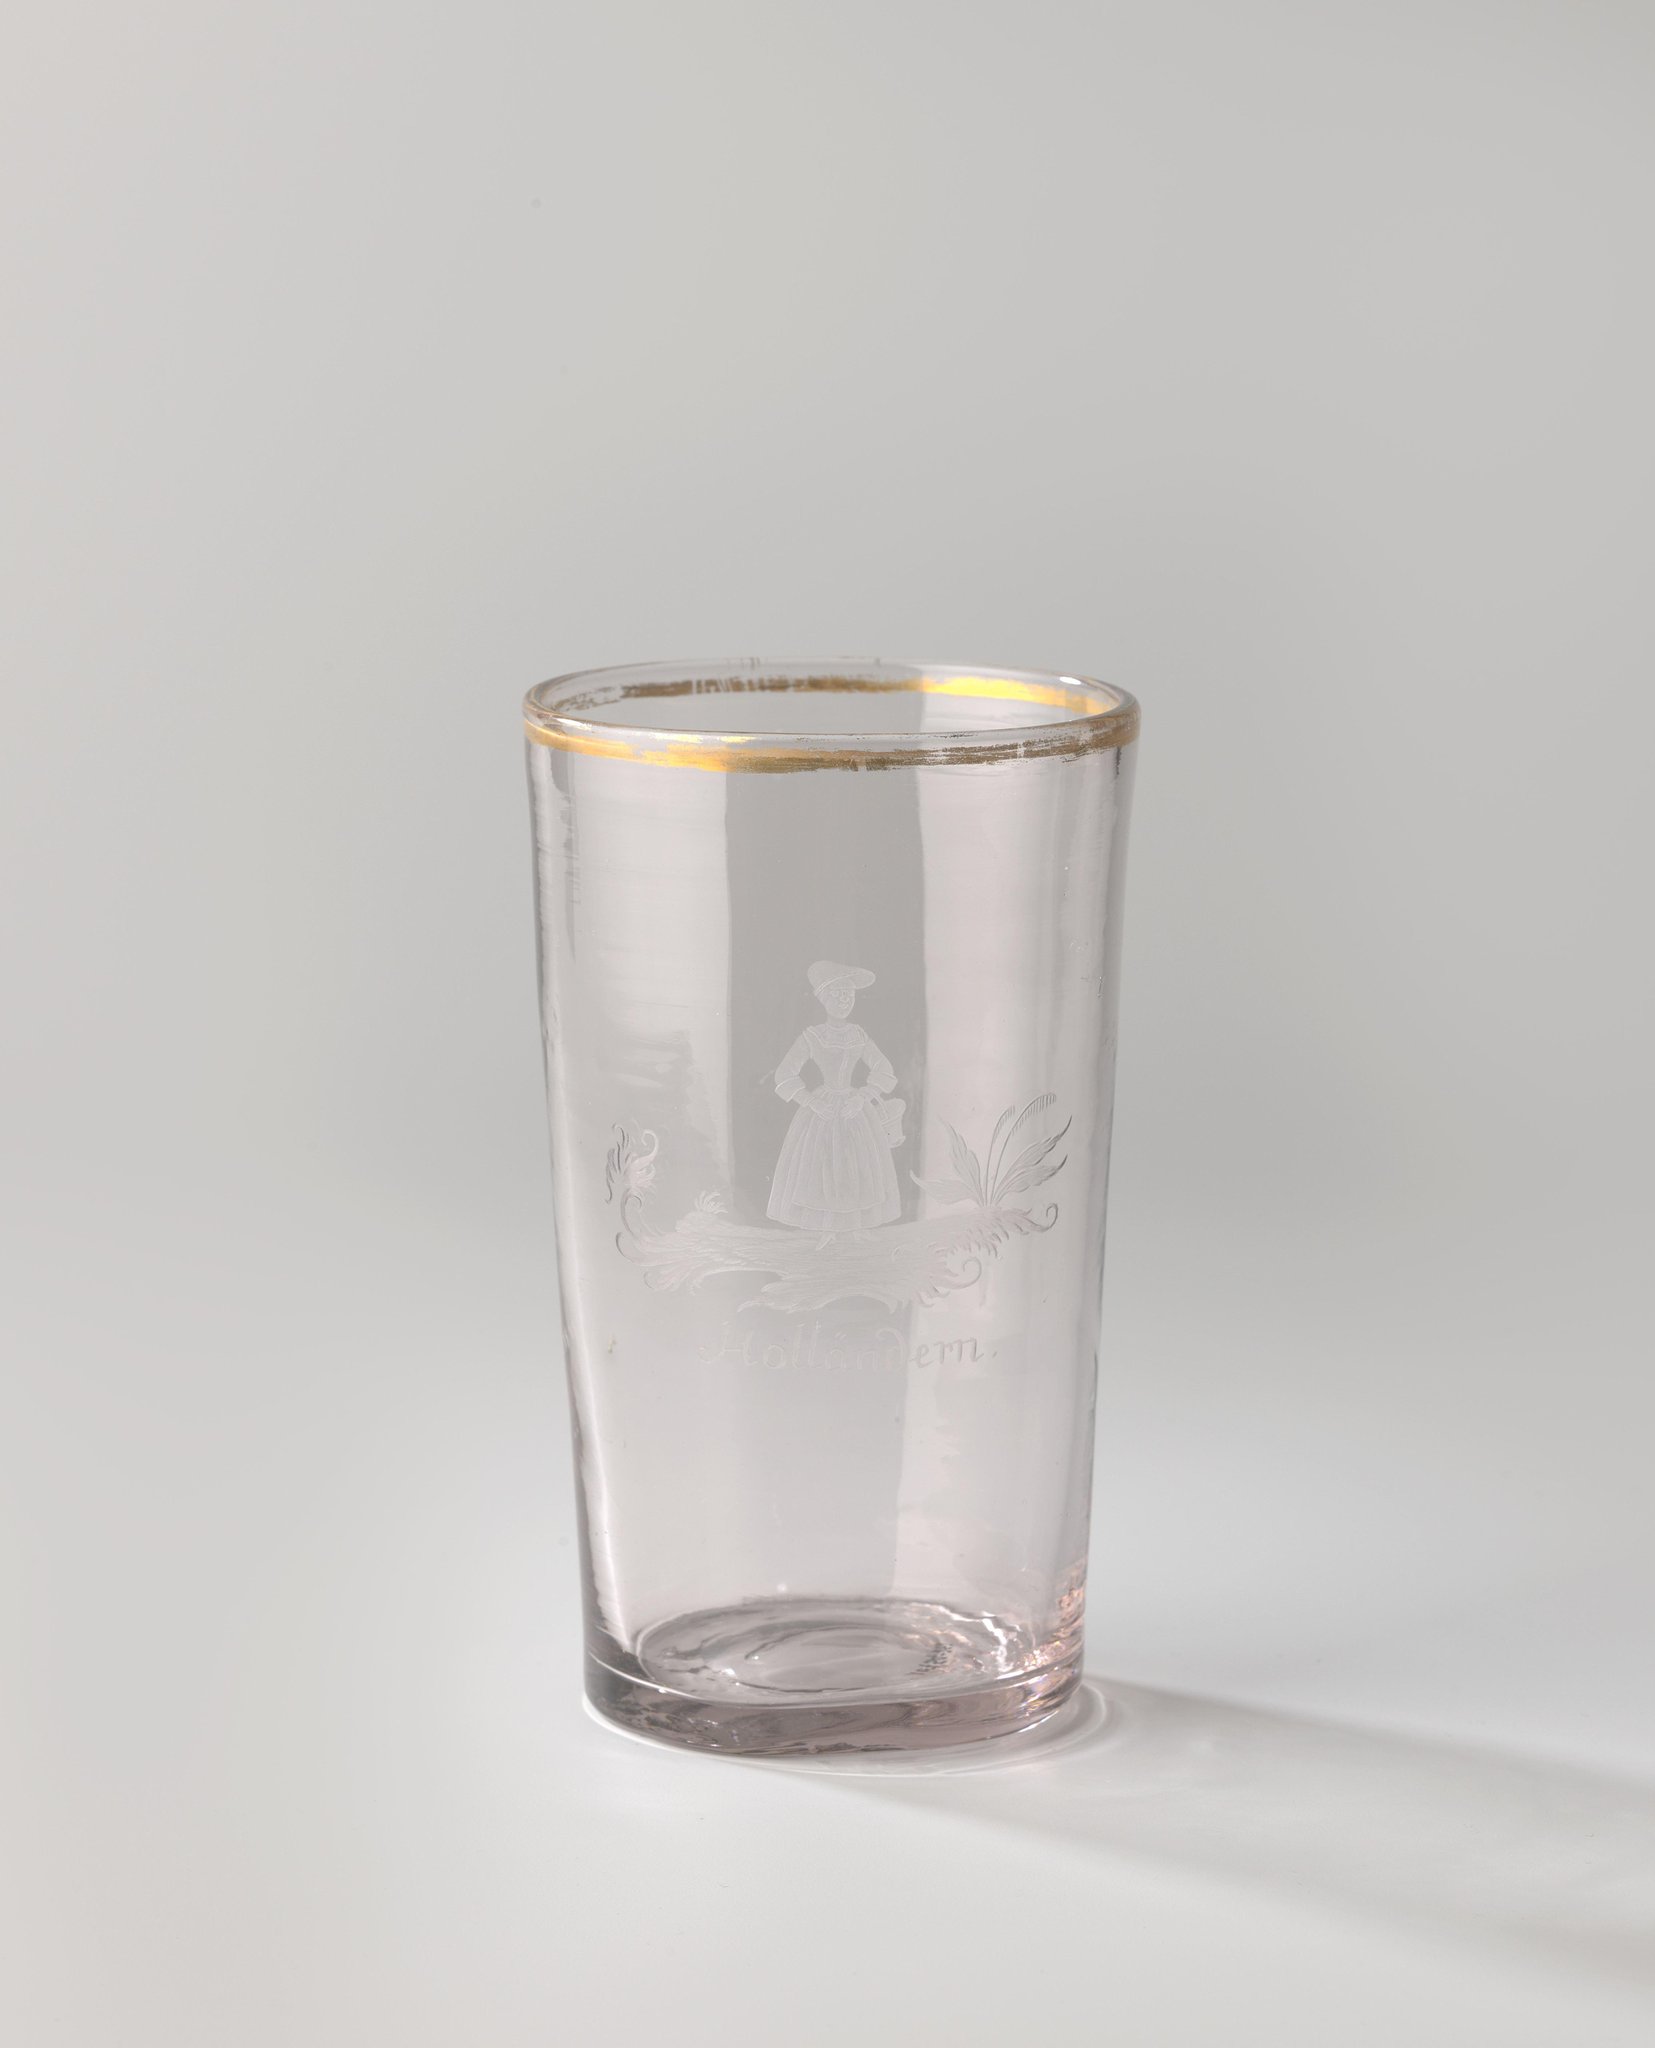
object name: cup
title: Beker met een Hollandse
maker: Anonymous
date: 1750-1800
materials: glass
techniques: gilding, glassblowing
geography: bohemia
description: Two beakers. Wheel engraving with a Russian and a Dutch woman. Bohemia, c. 1750 - 1800. A.J. Enschedé bequest, 1896.